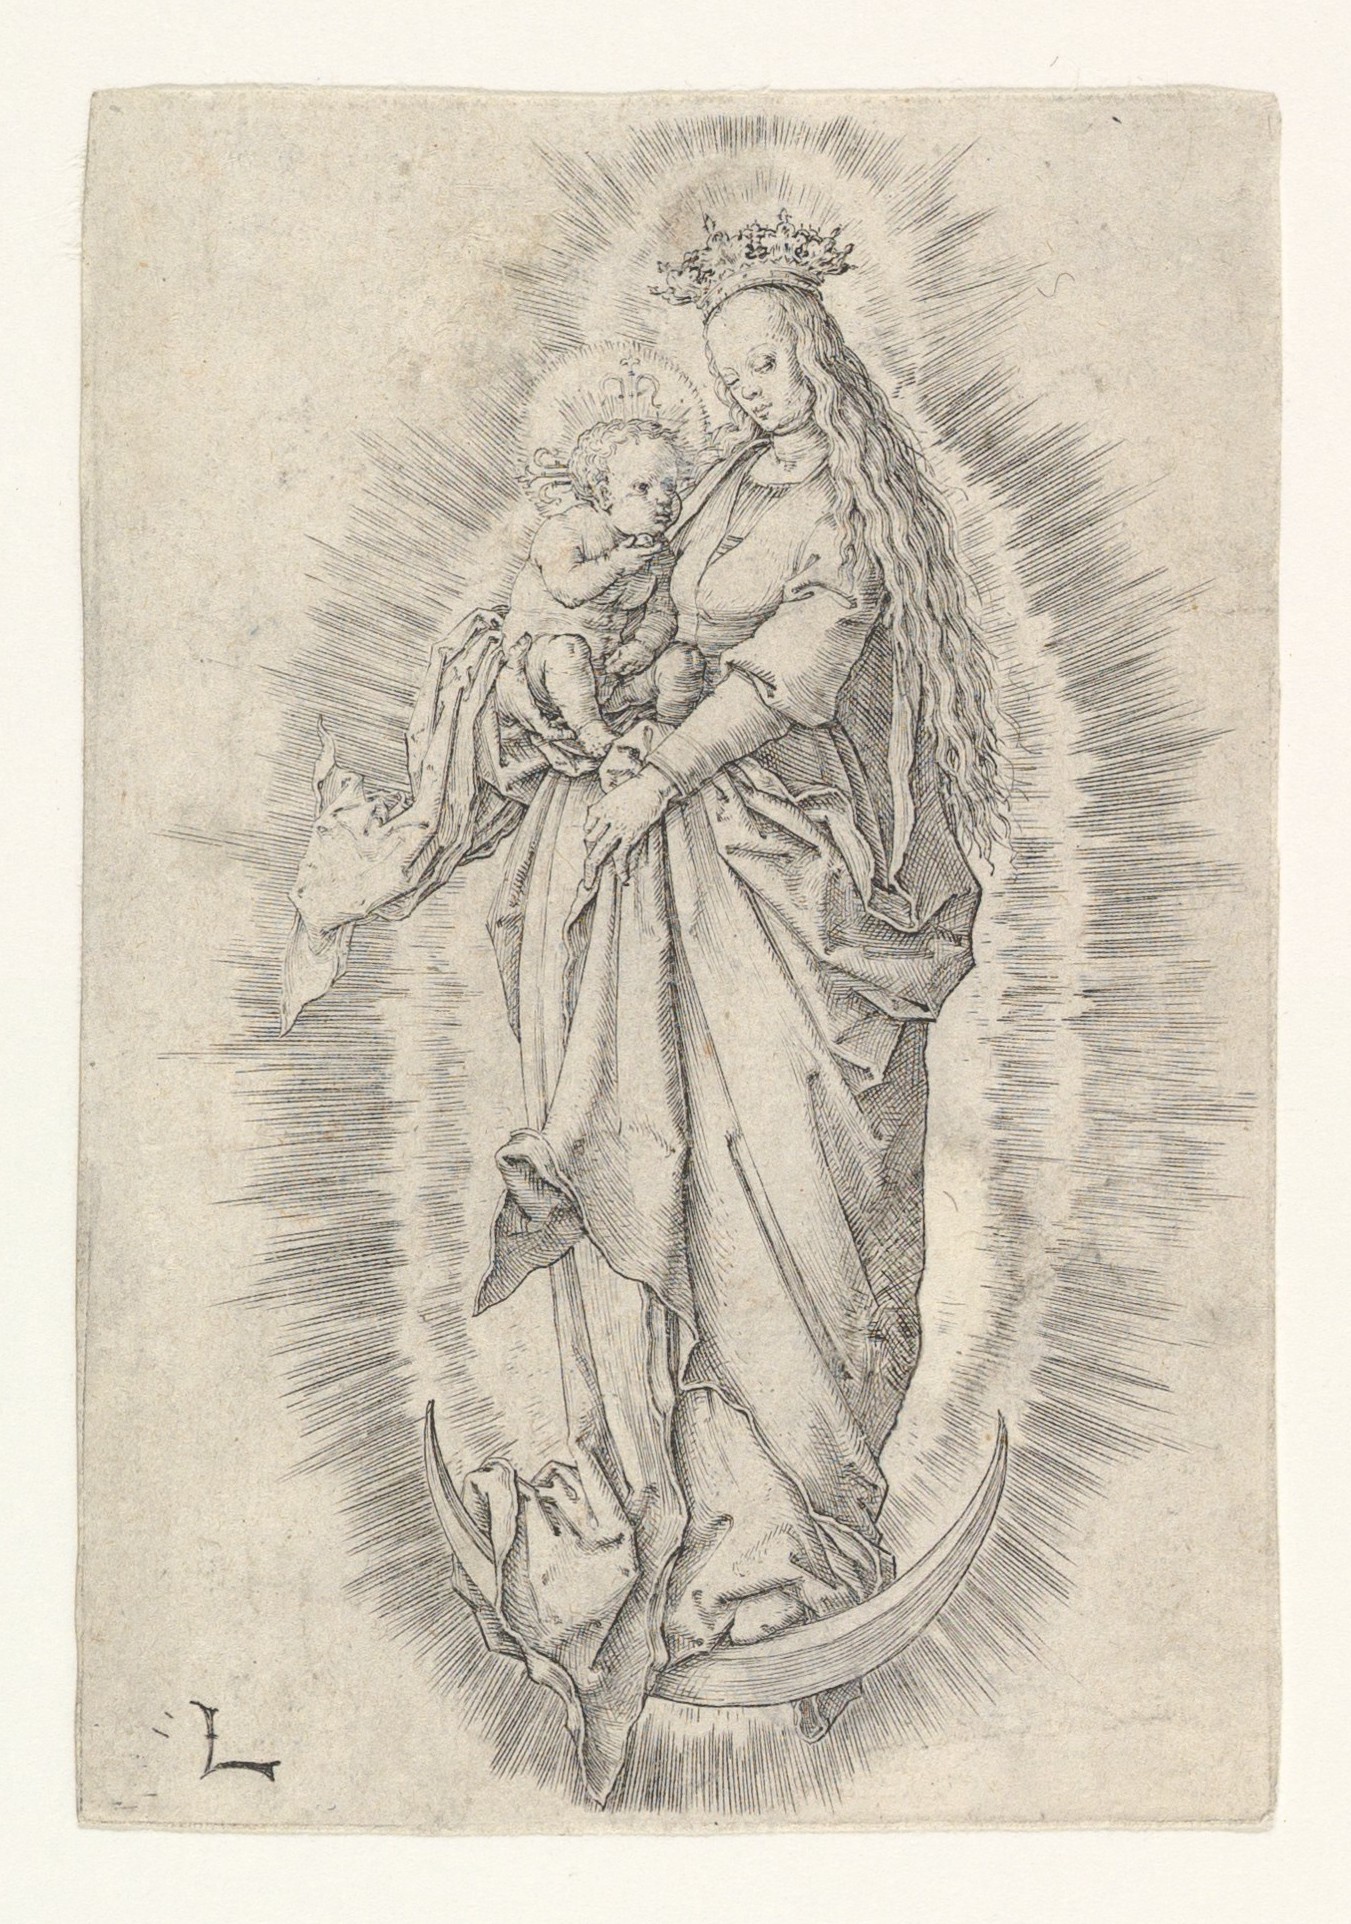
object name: print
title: The Crowned Virgin With Child in Glory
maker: lucas van leyden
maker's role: artist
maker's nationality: netherlandish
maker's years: 1494-1533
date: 1512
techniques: engraving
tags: madonna and child